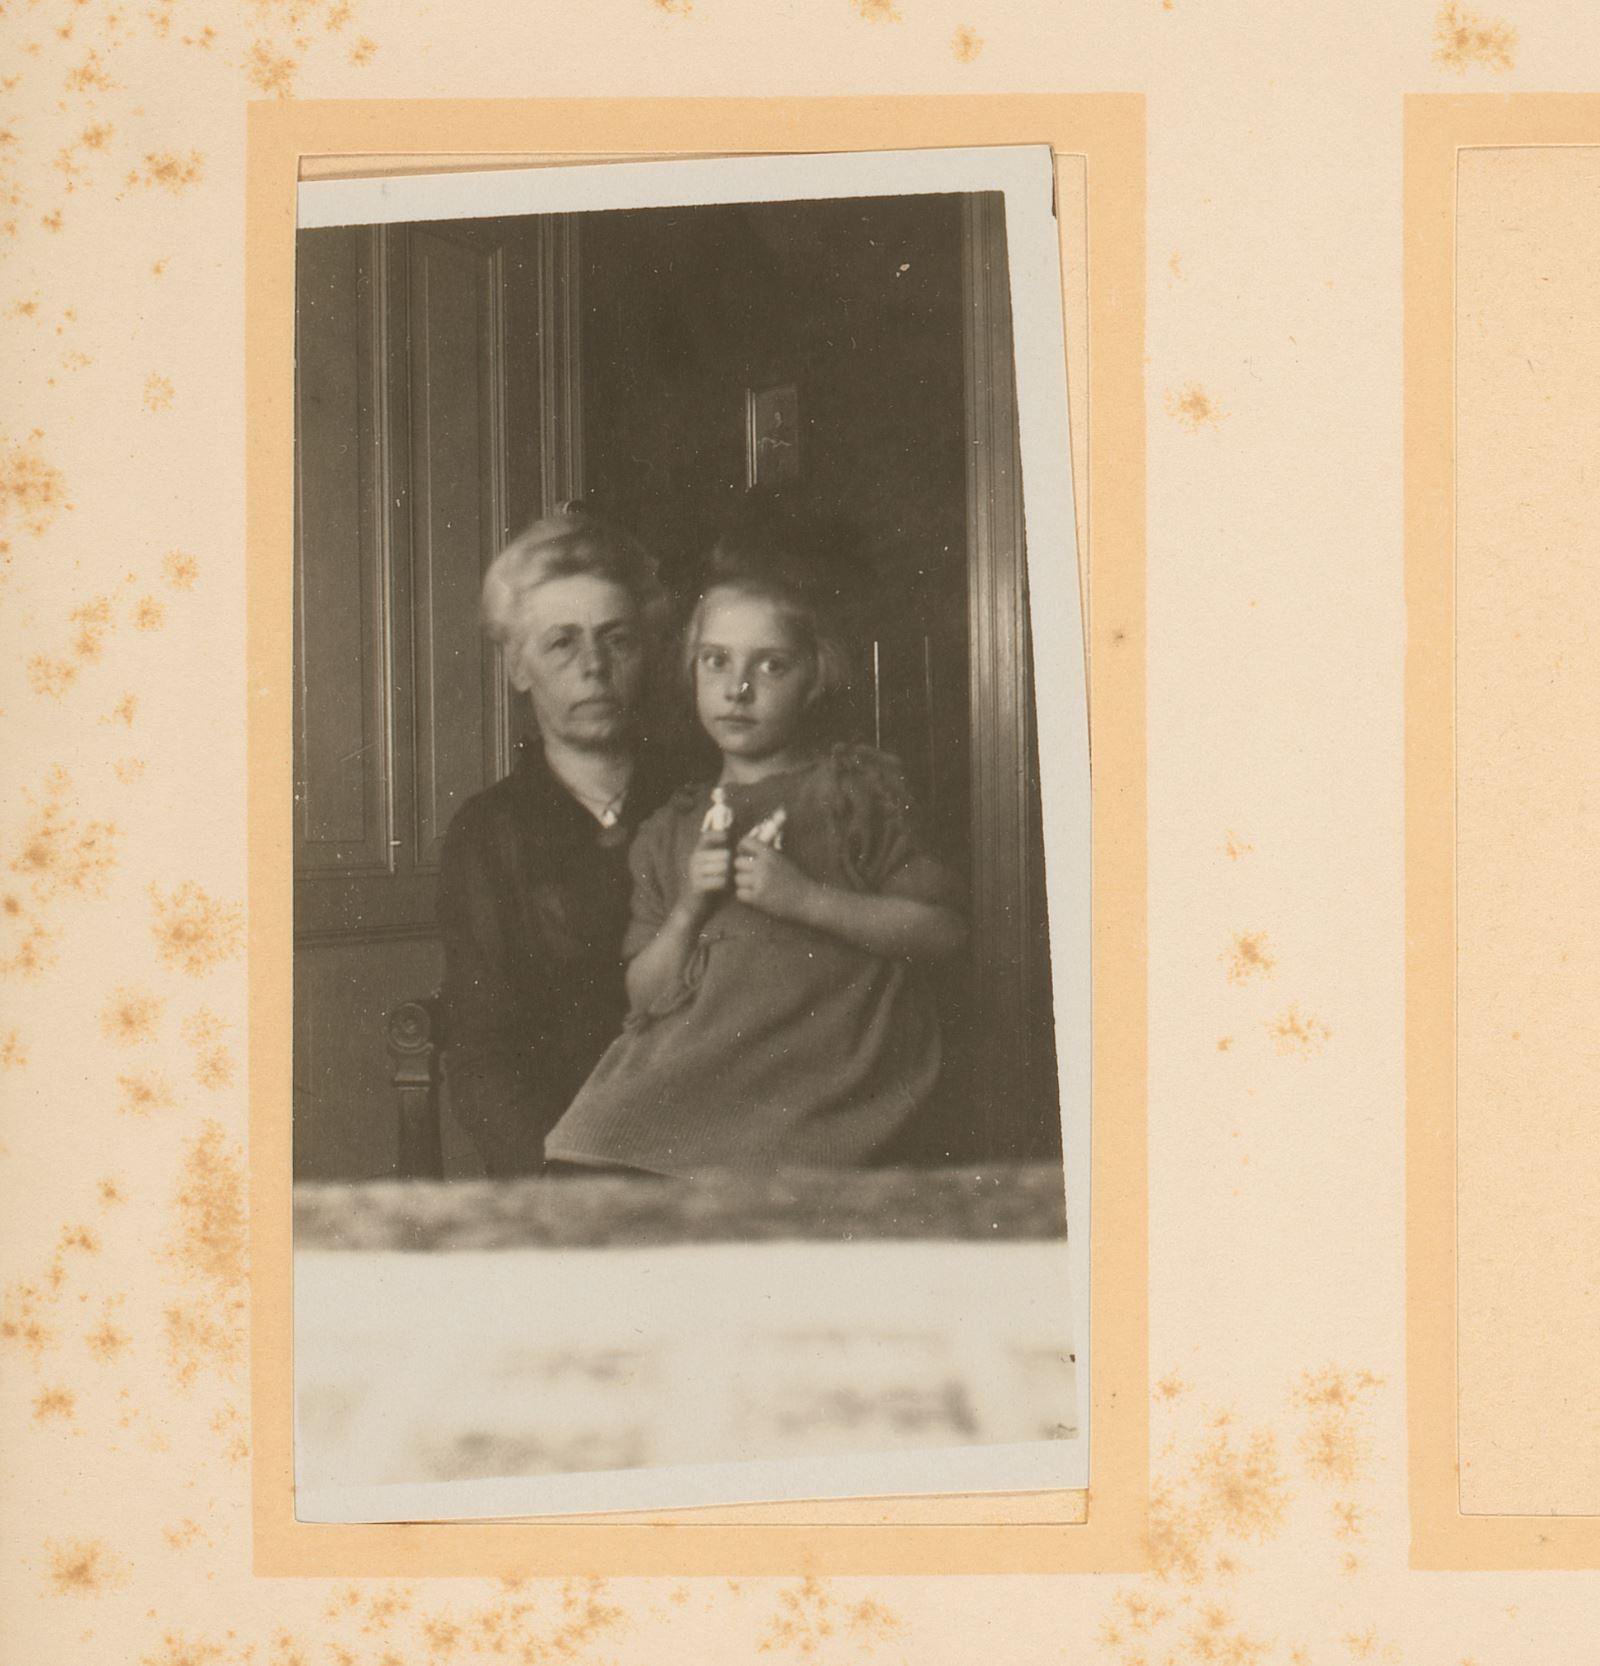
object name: album leaf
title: Dubbelportret van een oude vrouw en een meisje met poppen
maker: Anonymous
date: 1927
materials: paper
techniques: gelatin silver print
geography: netherlands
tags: girl (child between toddler and youth), old woman, netherlands